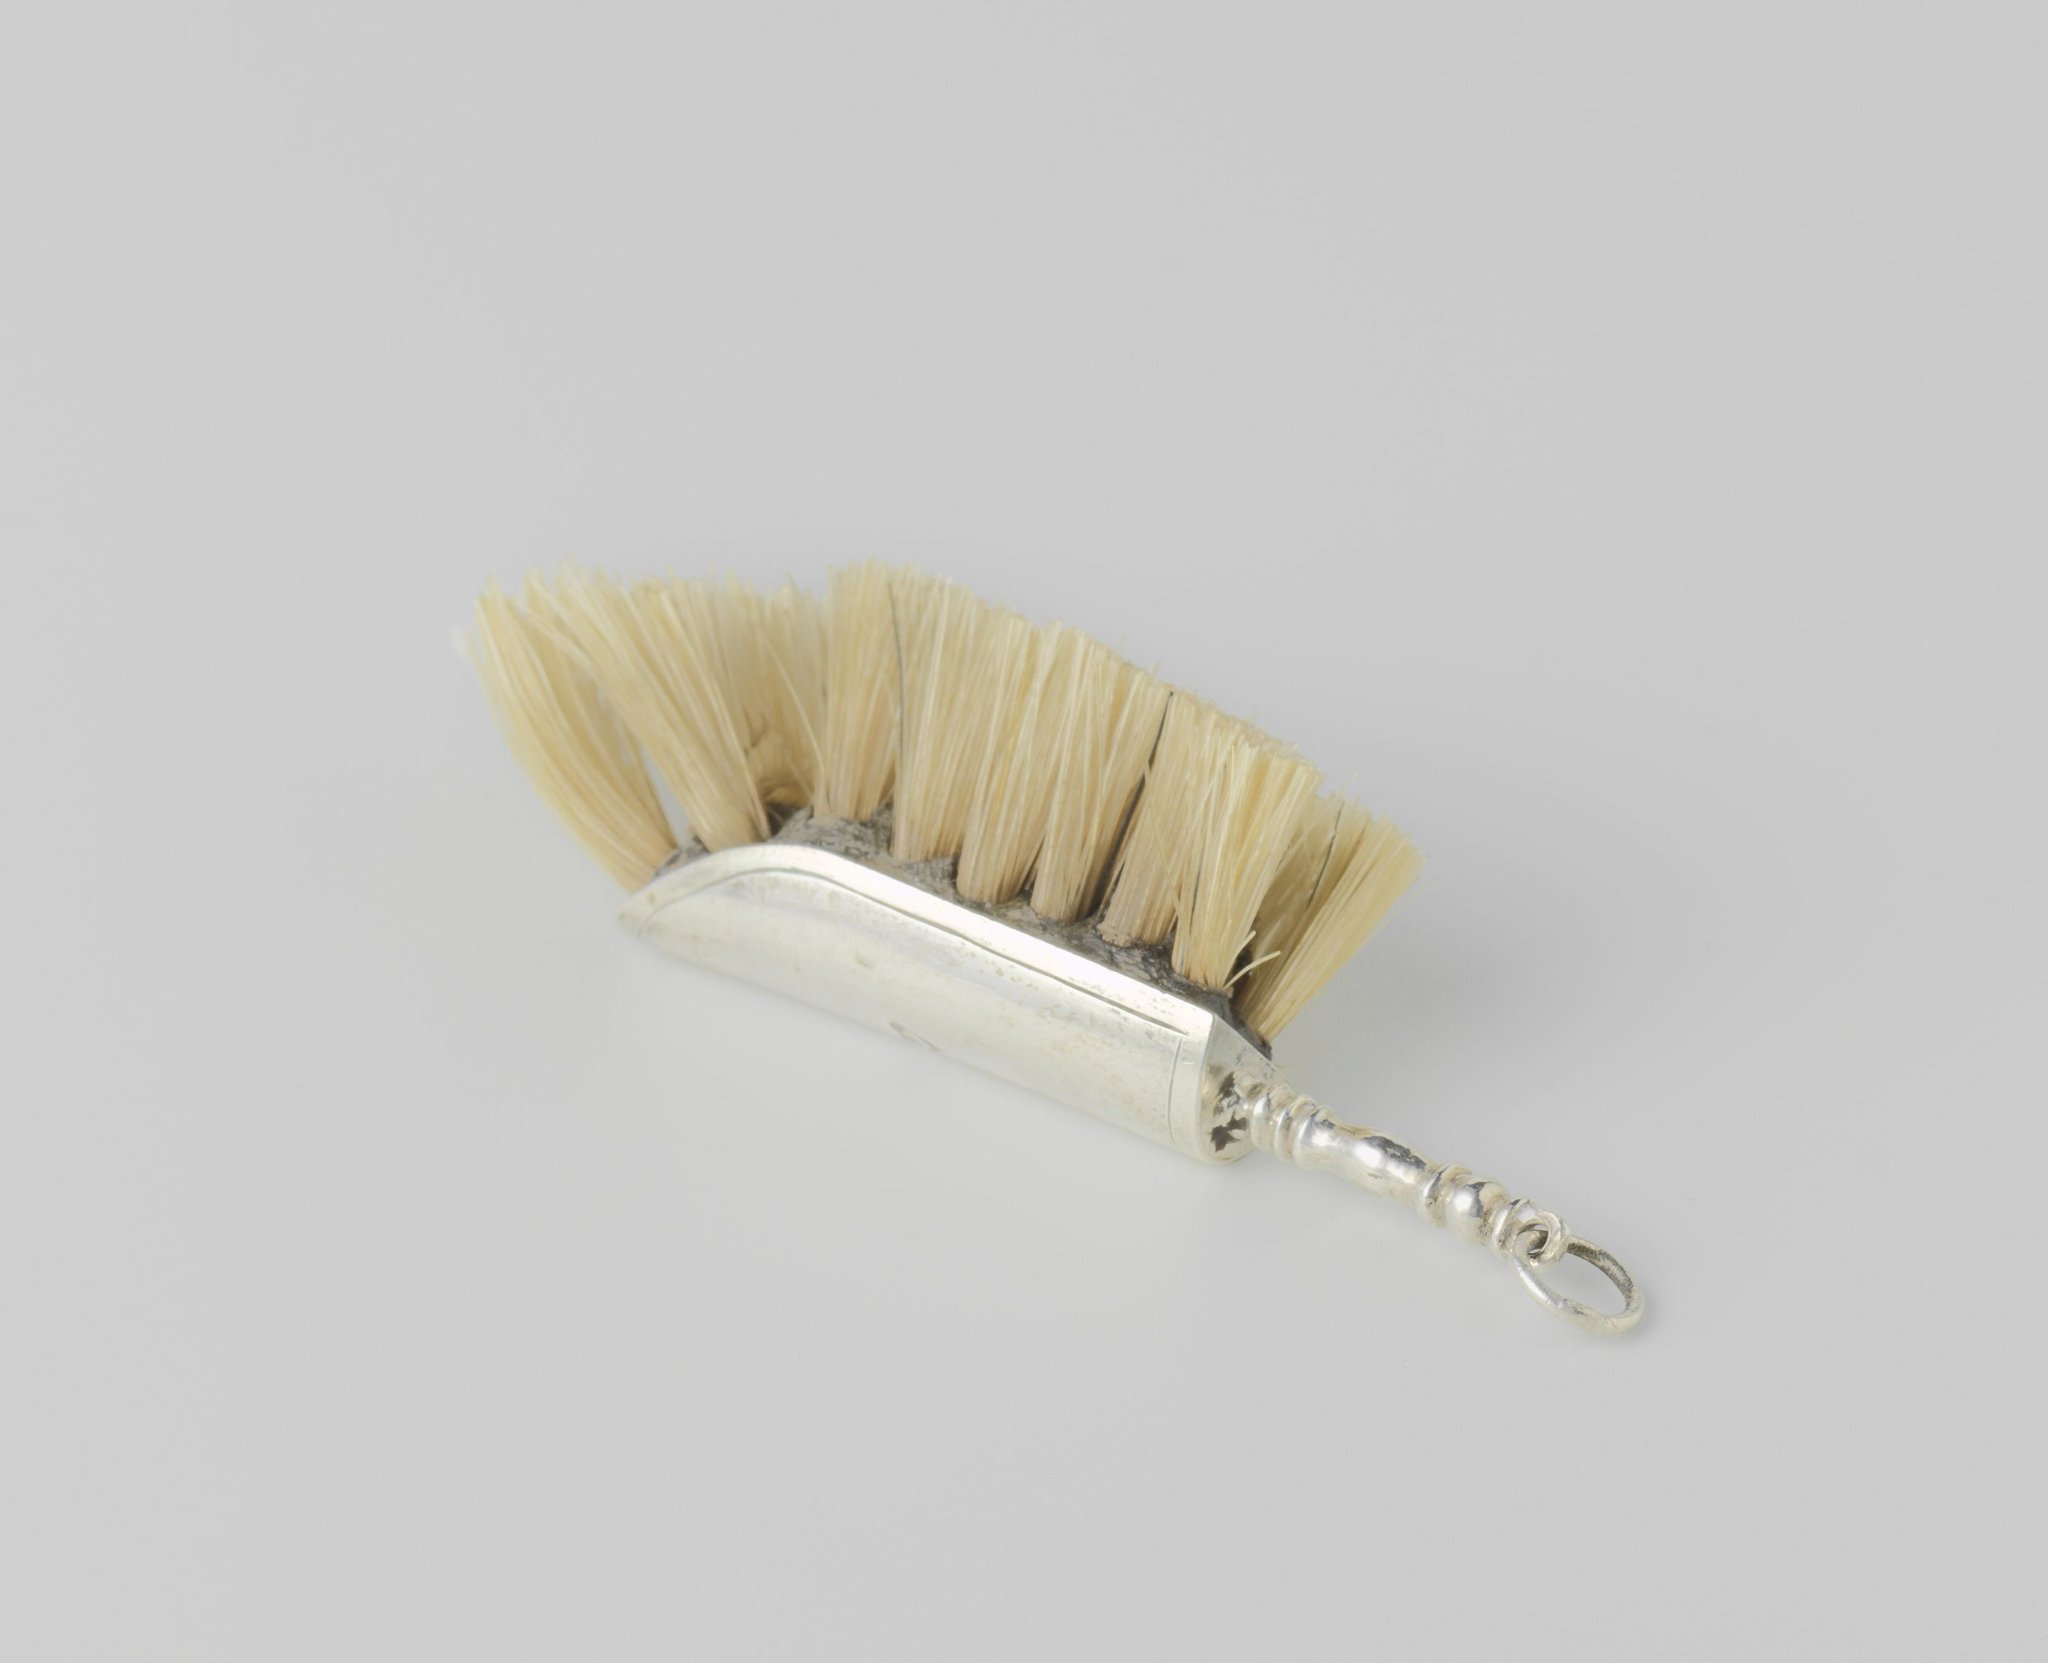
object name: miniature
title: Stoffer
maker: arnoldus van geffen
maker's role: silversmith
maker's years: 1700-1769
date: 1750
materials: silver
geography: amsterdam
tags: (household) utensils and implements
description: Stoffer met een ronde rug en een geprofileerd handvat met aan het eind een ring. De stoffer is gemerkt: mt.= Arnoldus van Geffen en een dolfijn.